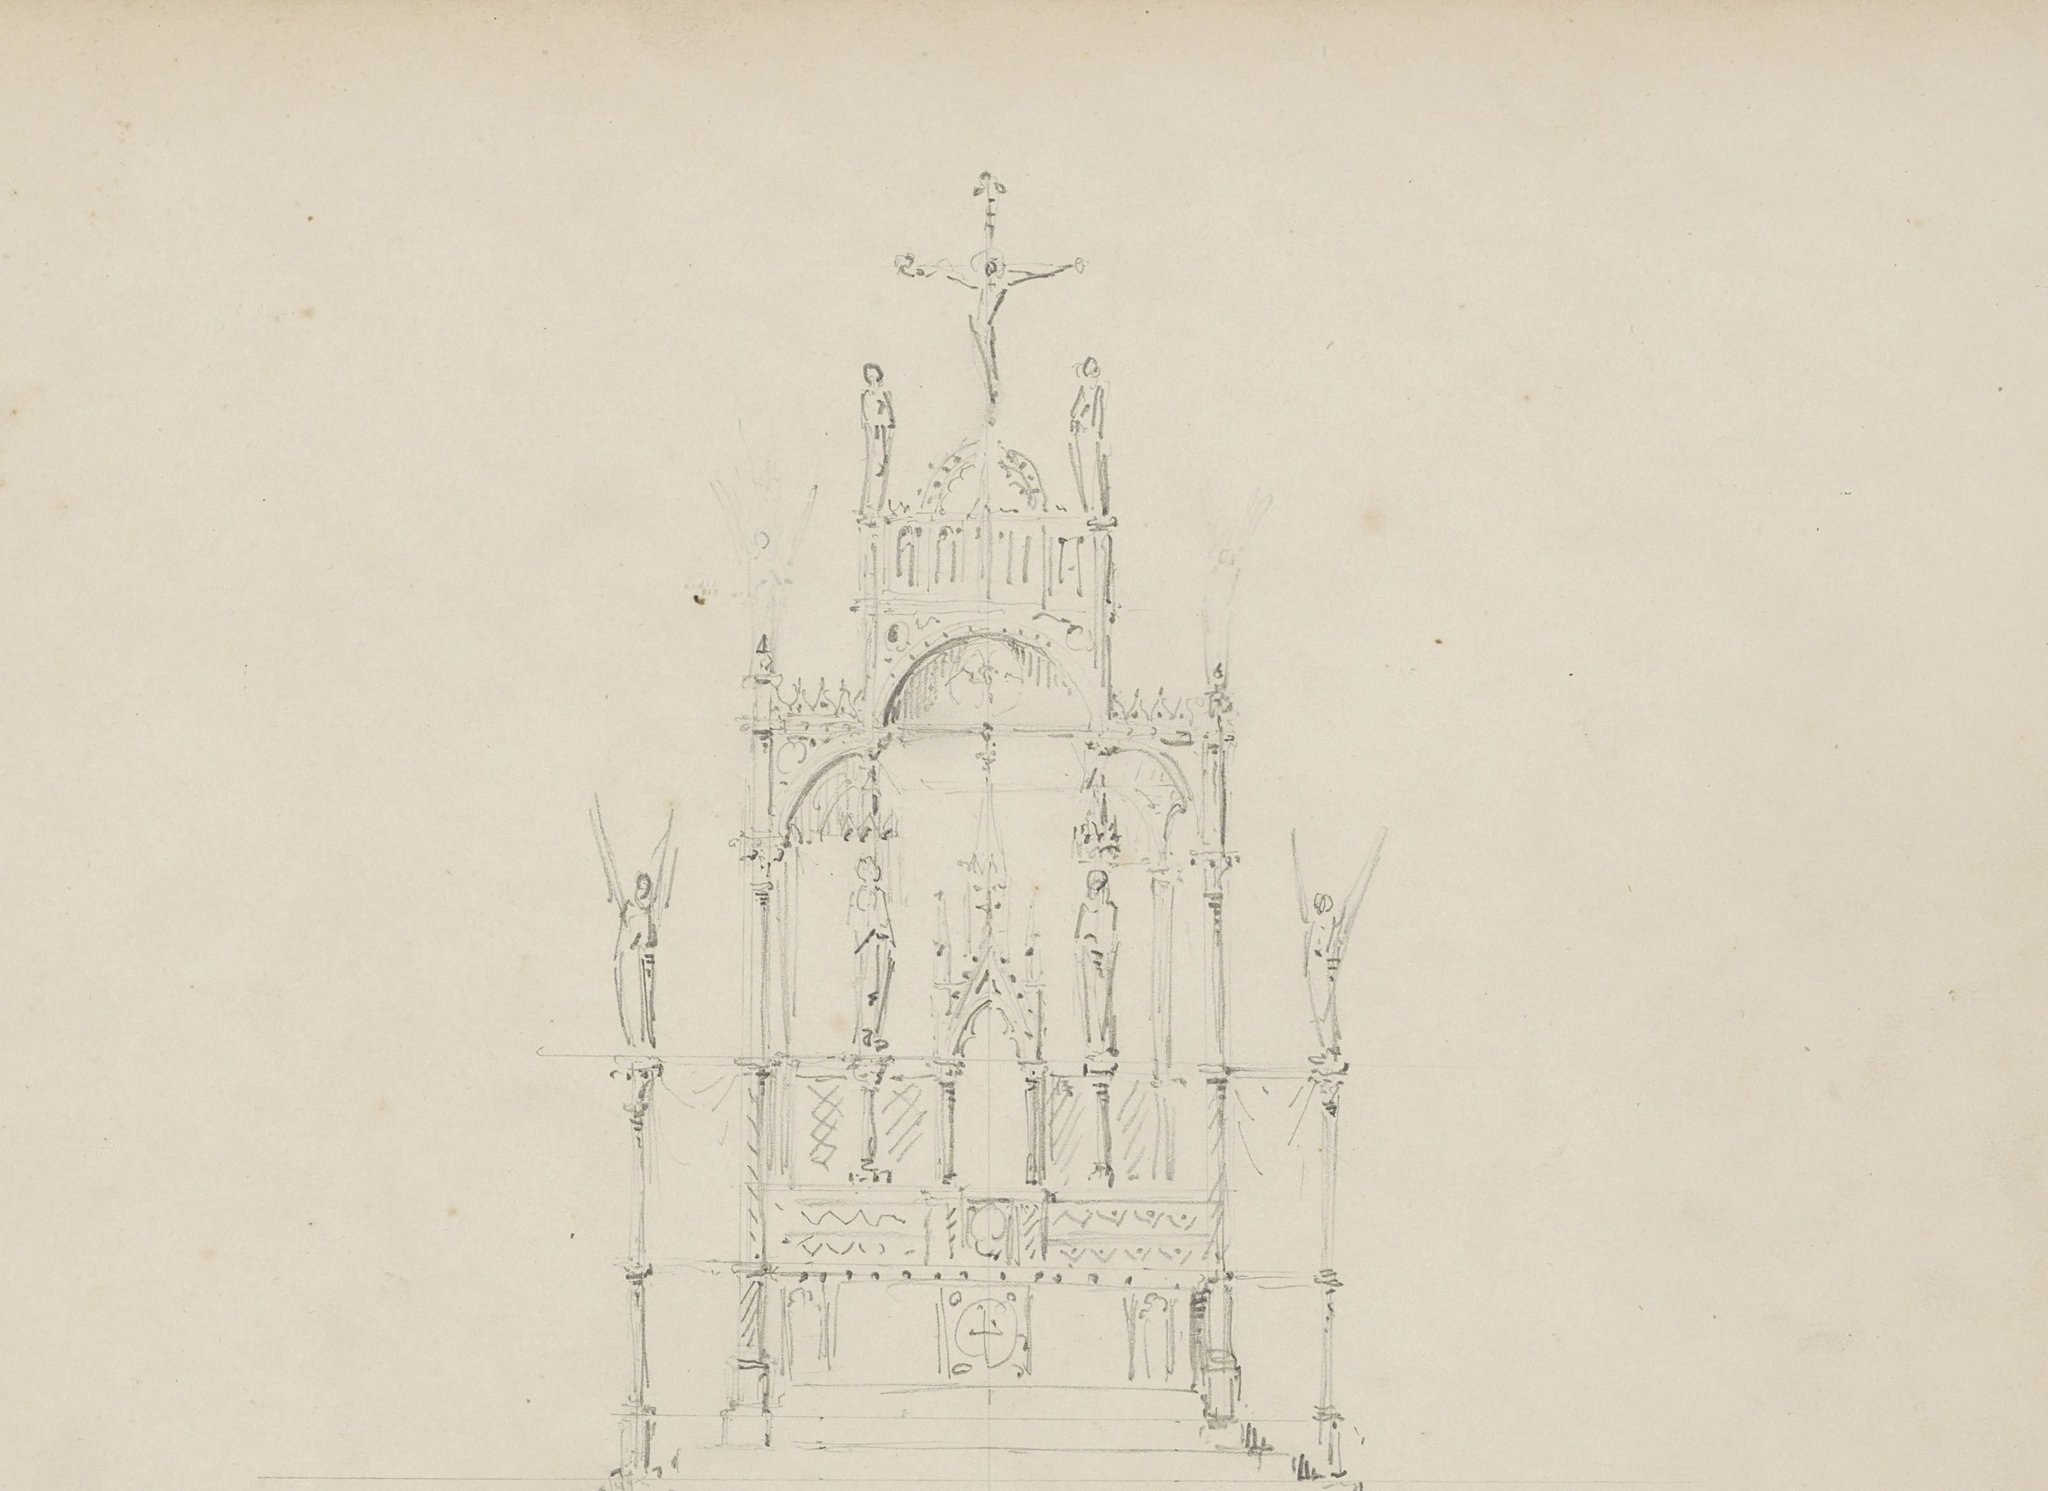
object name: sketchbook leaf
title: Altaar, Hilvarenbeek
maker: pierre joseph hubert cuypers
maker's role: draughtsman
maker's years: 1827-1921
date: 1857-1859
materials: paper, pencil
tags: altar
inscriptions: annotation: ‘Hilvarenbeek’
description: Titel gebaseerd op inhoudsopgave door Cuypers op blad 77 recto.